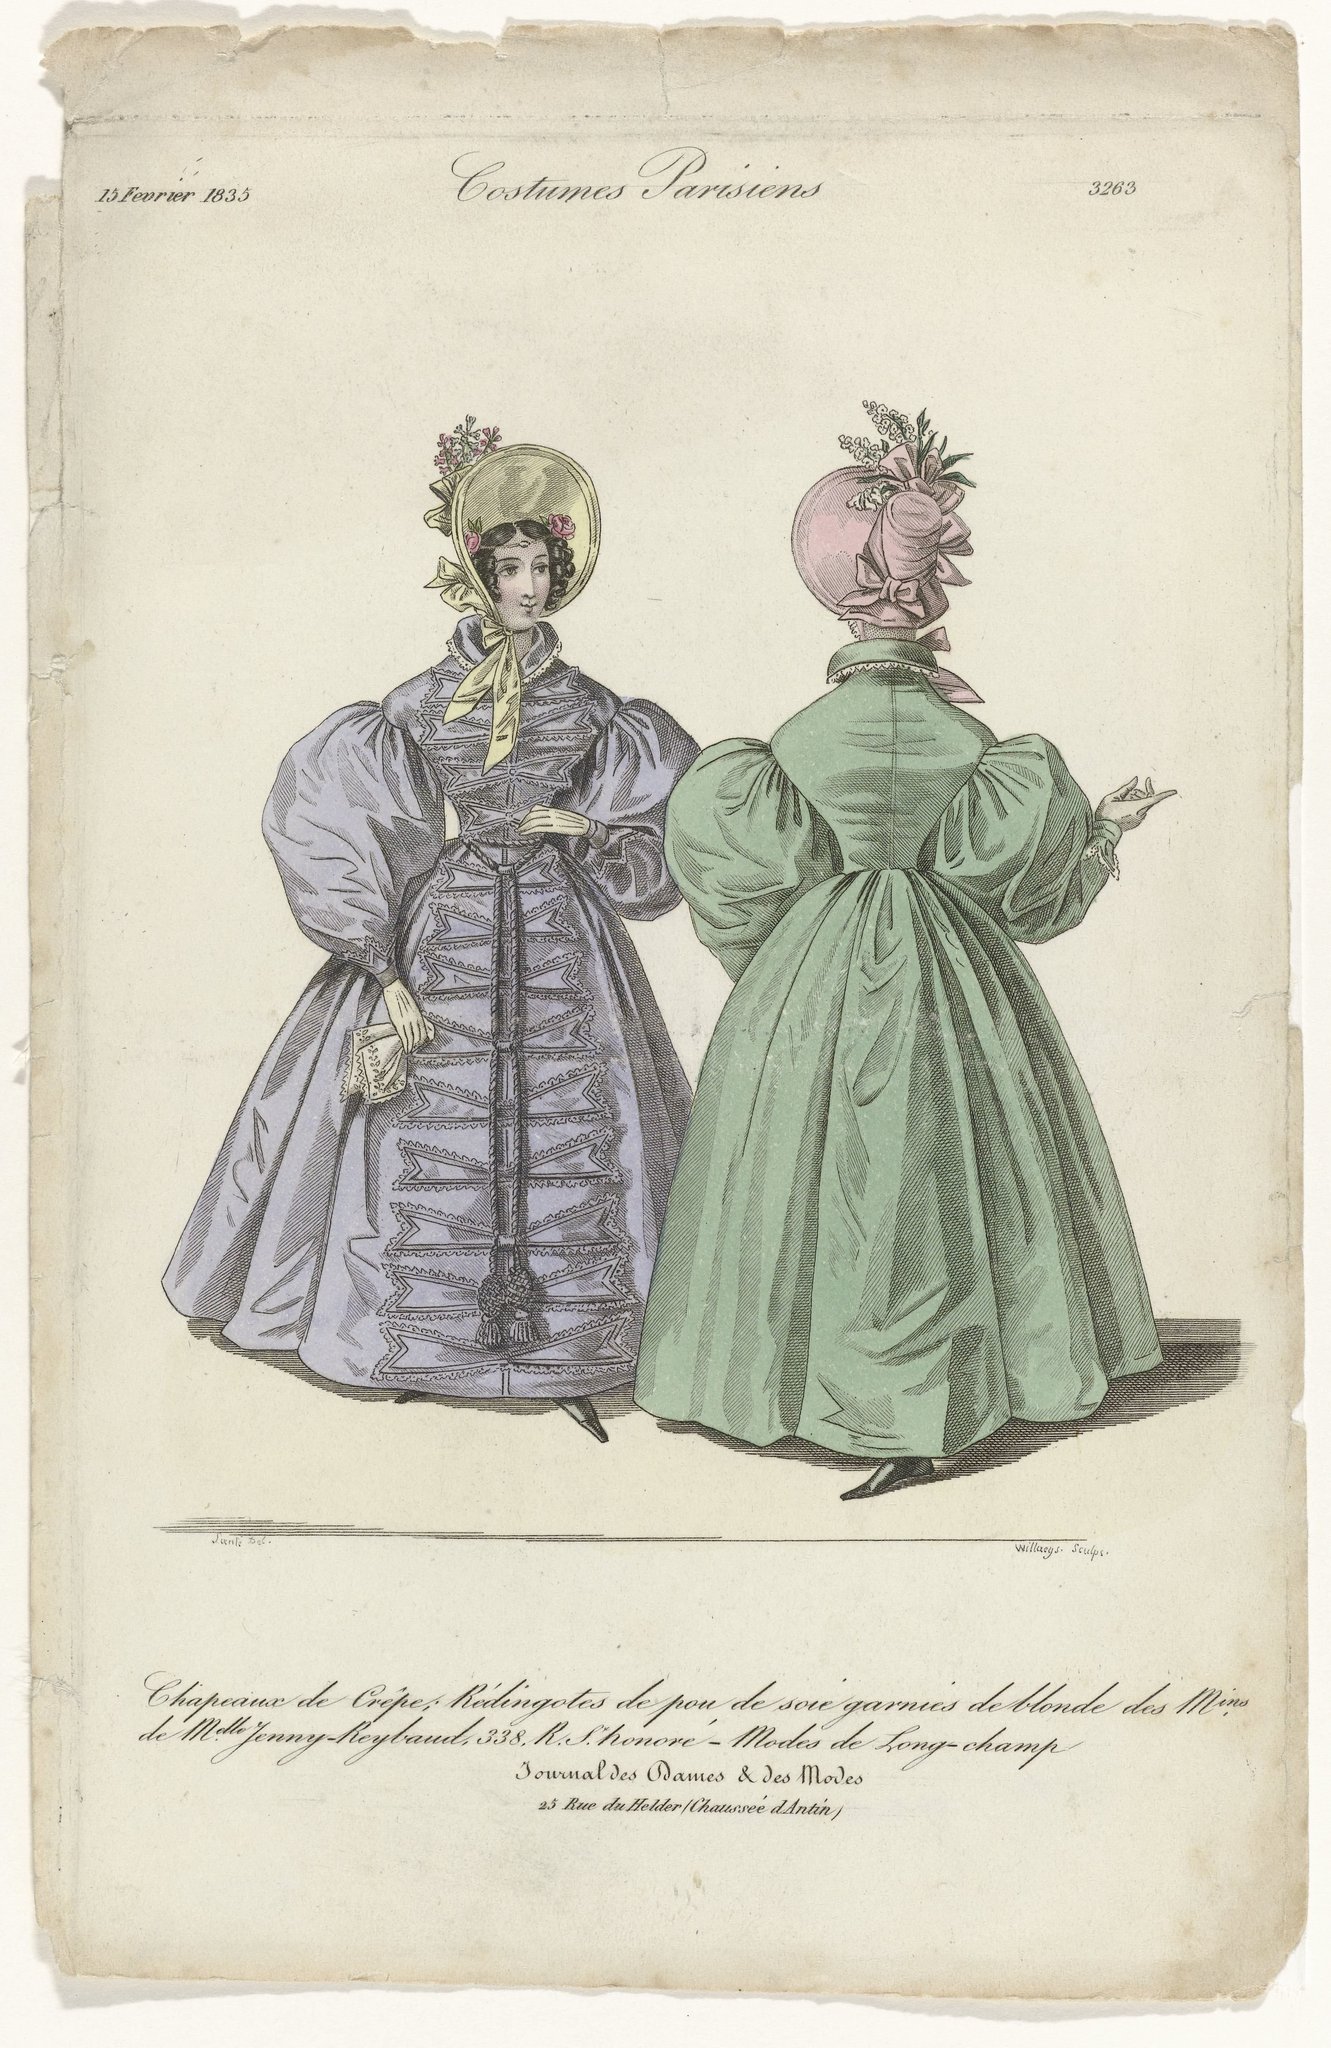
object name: fashion print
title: Journal des Dames et des Modes, 15 fevrier 1835 , No. 3263 : Chapeaux de crêpe; (...)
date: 1835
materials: paper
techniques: engraving, hand coloring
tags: dress, gown: redingote (+ women's clothes), ornamental parts of clothing (+ lace used for clothes), fashion plates, head-gear: hat (+ women's clothes), fan (+ women's clothes), belt, girdle, waistband (+ women's clothes)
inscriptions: address: ‘Journal des Dames & des Modes / 25 Rue du Helder (Chaussée d Antin)’, title: ‘Costumes Parisiens’, caption: ‘Chapeaux de Crêpe; Rédingotes de pou de soie garnies de blonde des Mins de Melle Jenny-Reybaud, 338. R.S.t honoré - Modes de Long-champ’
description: Twee vrouwen, van wie één op de rug gezien. Volgens het onderschrift: hoeden van crêpe. Redingotes van 'pou de soie' gegarneerd met Blonde (kloskant) uit de winkels van Jeny-Reybaud. 'Modes de Longchamp'. De prent maakt deel uit van het modetijdschrift Journal des Dames et des Modes, Parijs, 1797-1839.